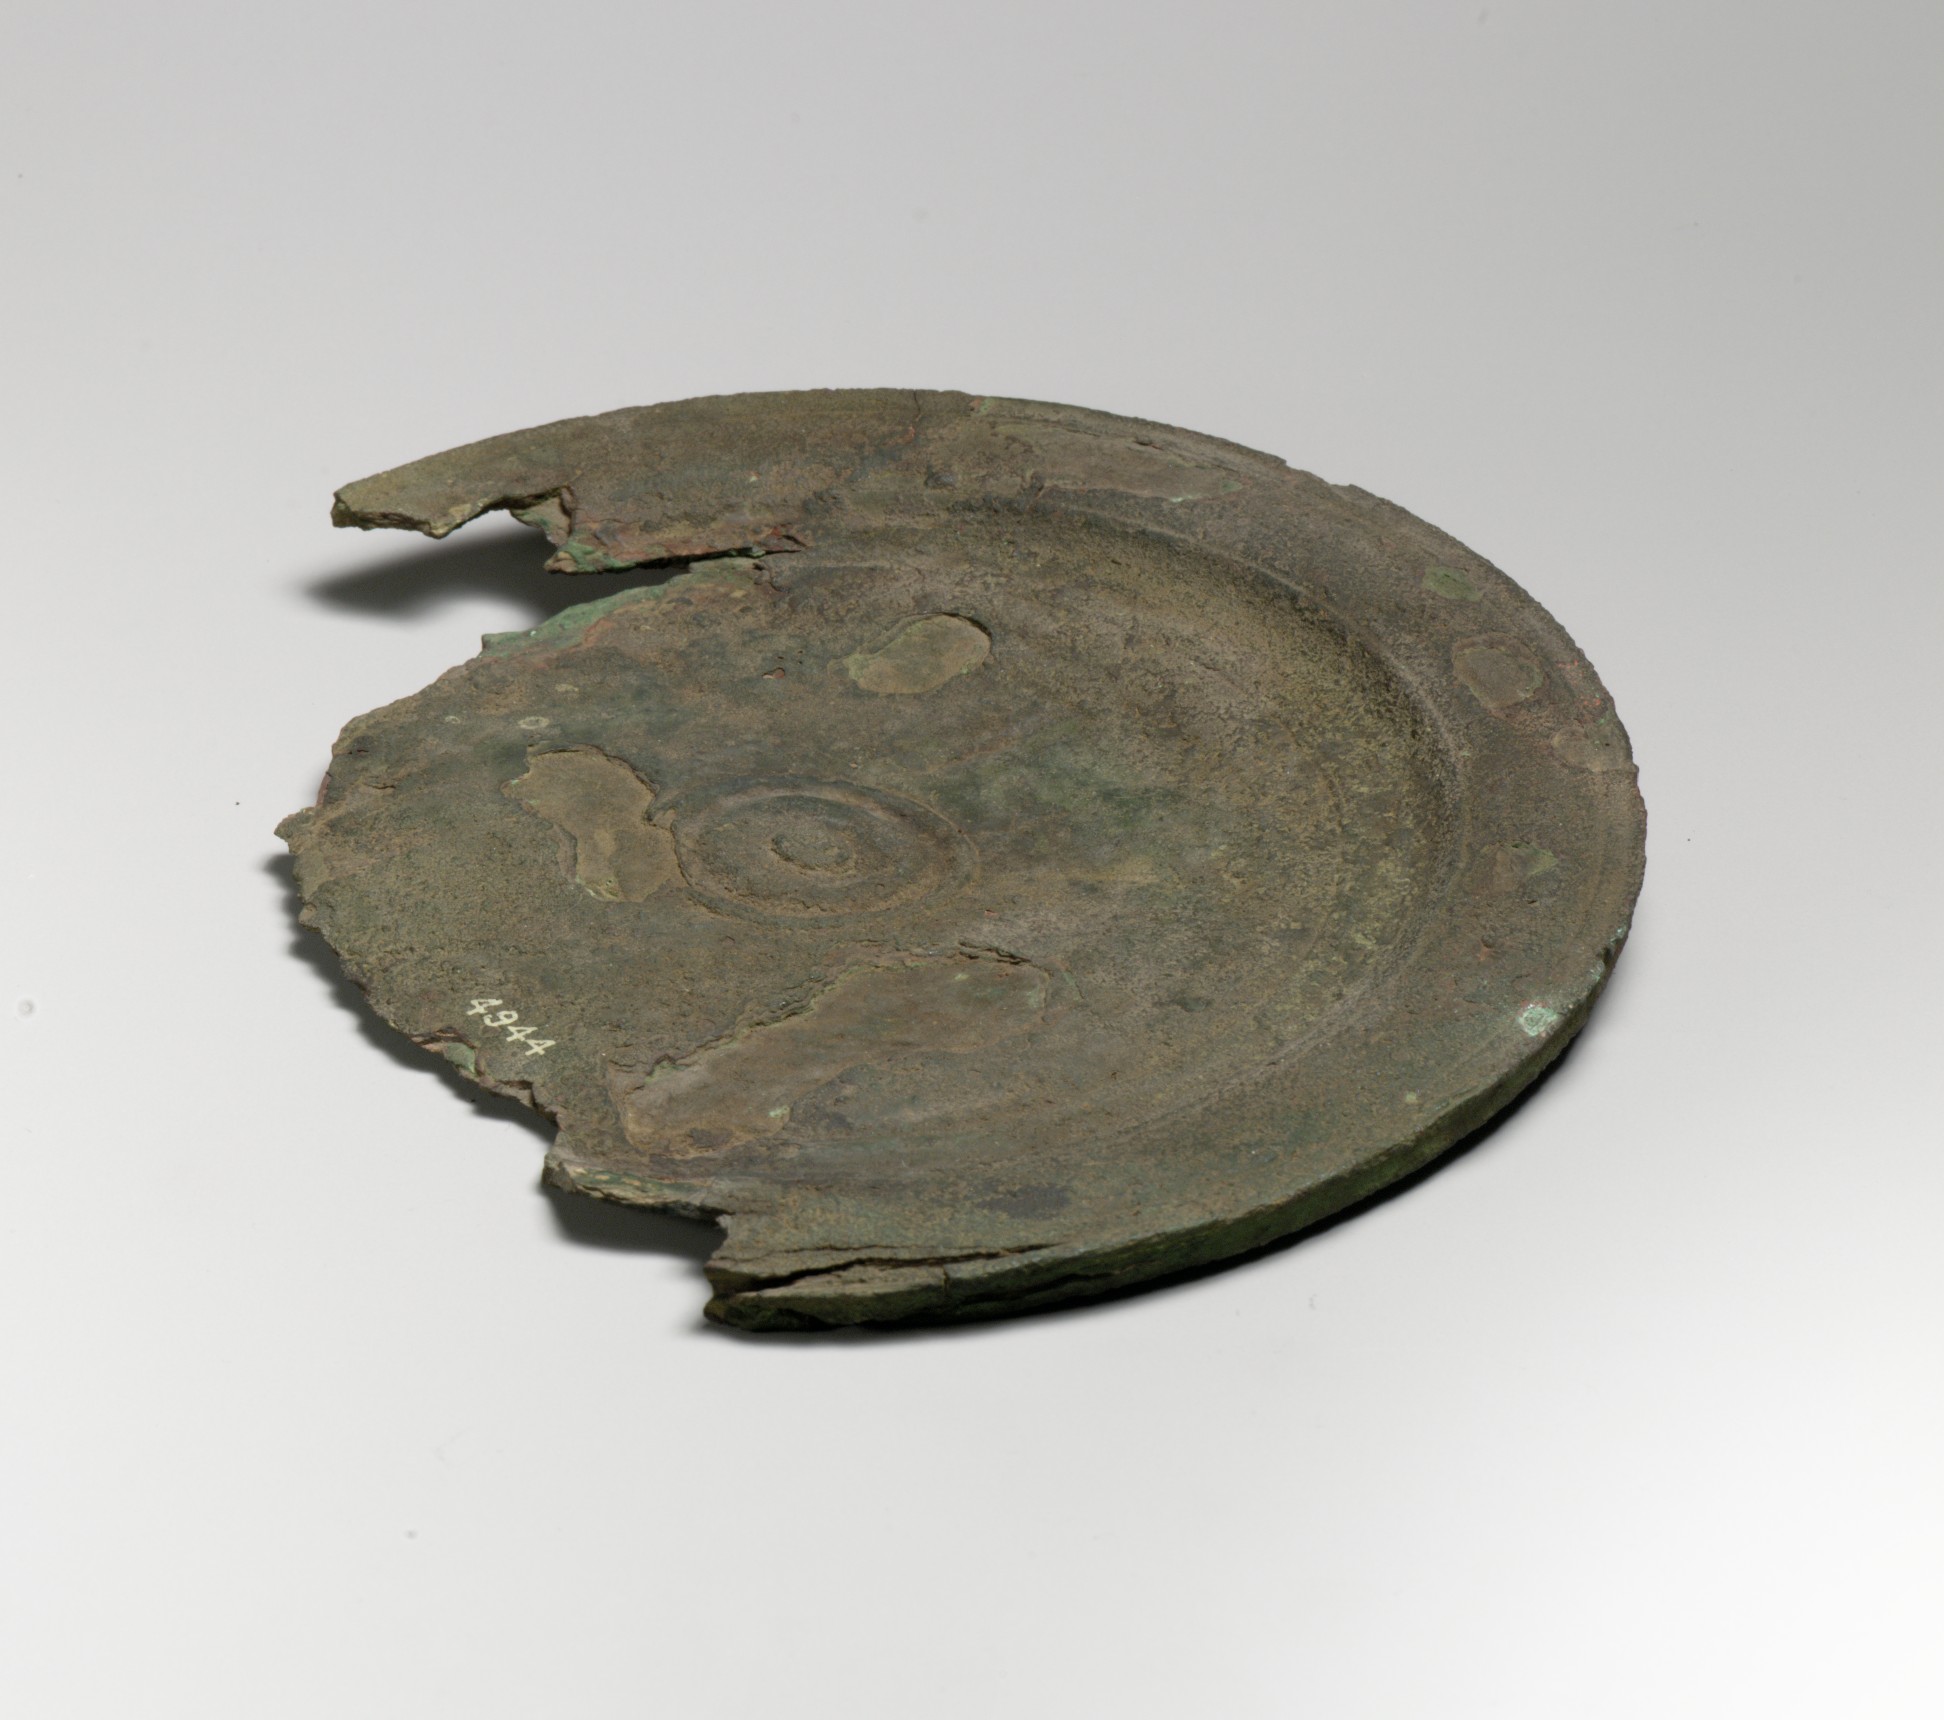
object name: plate with medallion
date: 7000 BCE-330 CE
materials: bronze